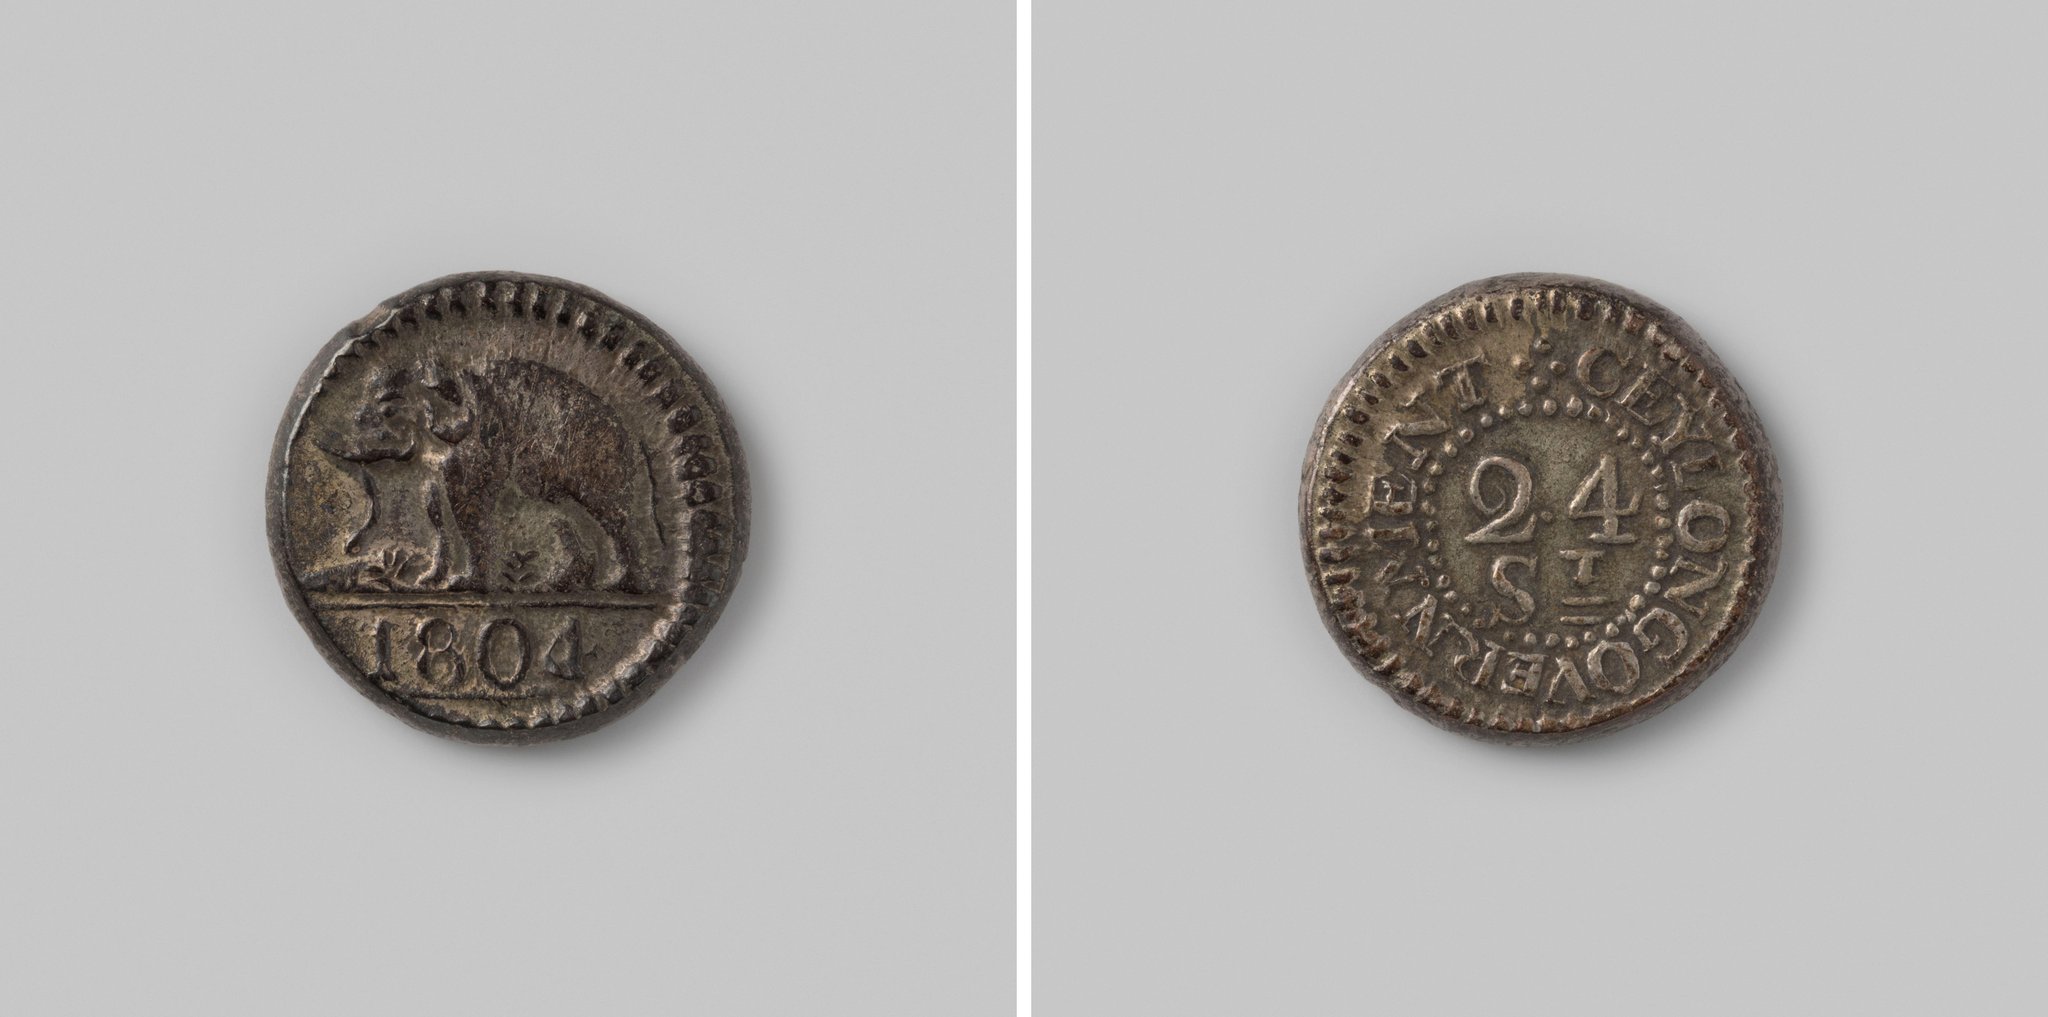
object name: coin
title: ½ rixdollar van 24 stivers van Sri Lanka, Ceylon, 1804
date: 1804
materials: silver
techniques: striking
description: Zilveren munt. Voorzijde: lopende olifant naar links. In afsnede jaartal onderaan. Keerzijde: binnen cirkel van stippen in twee regels waarde-aanduiding: 24 St. Gladde rand. Geslagen in Ceylon.